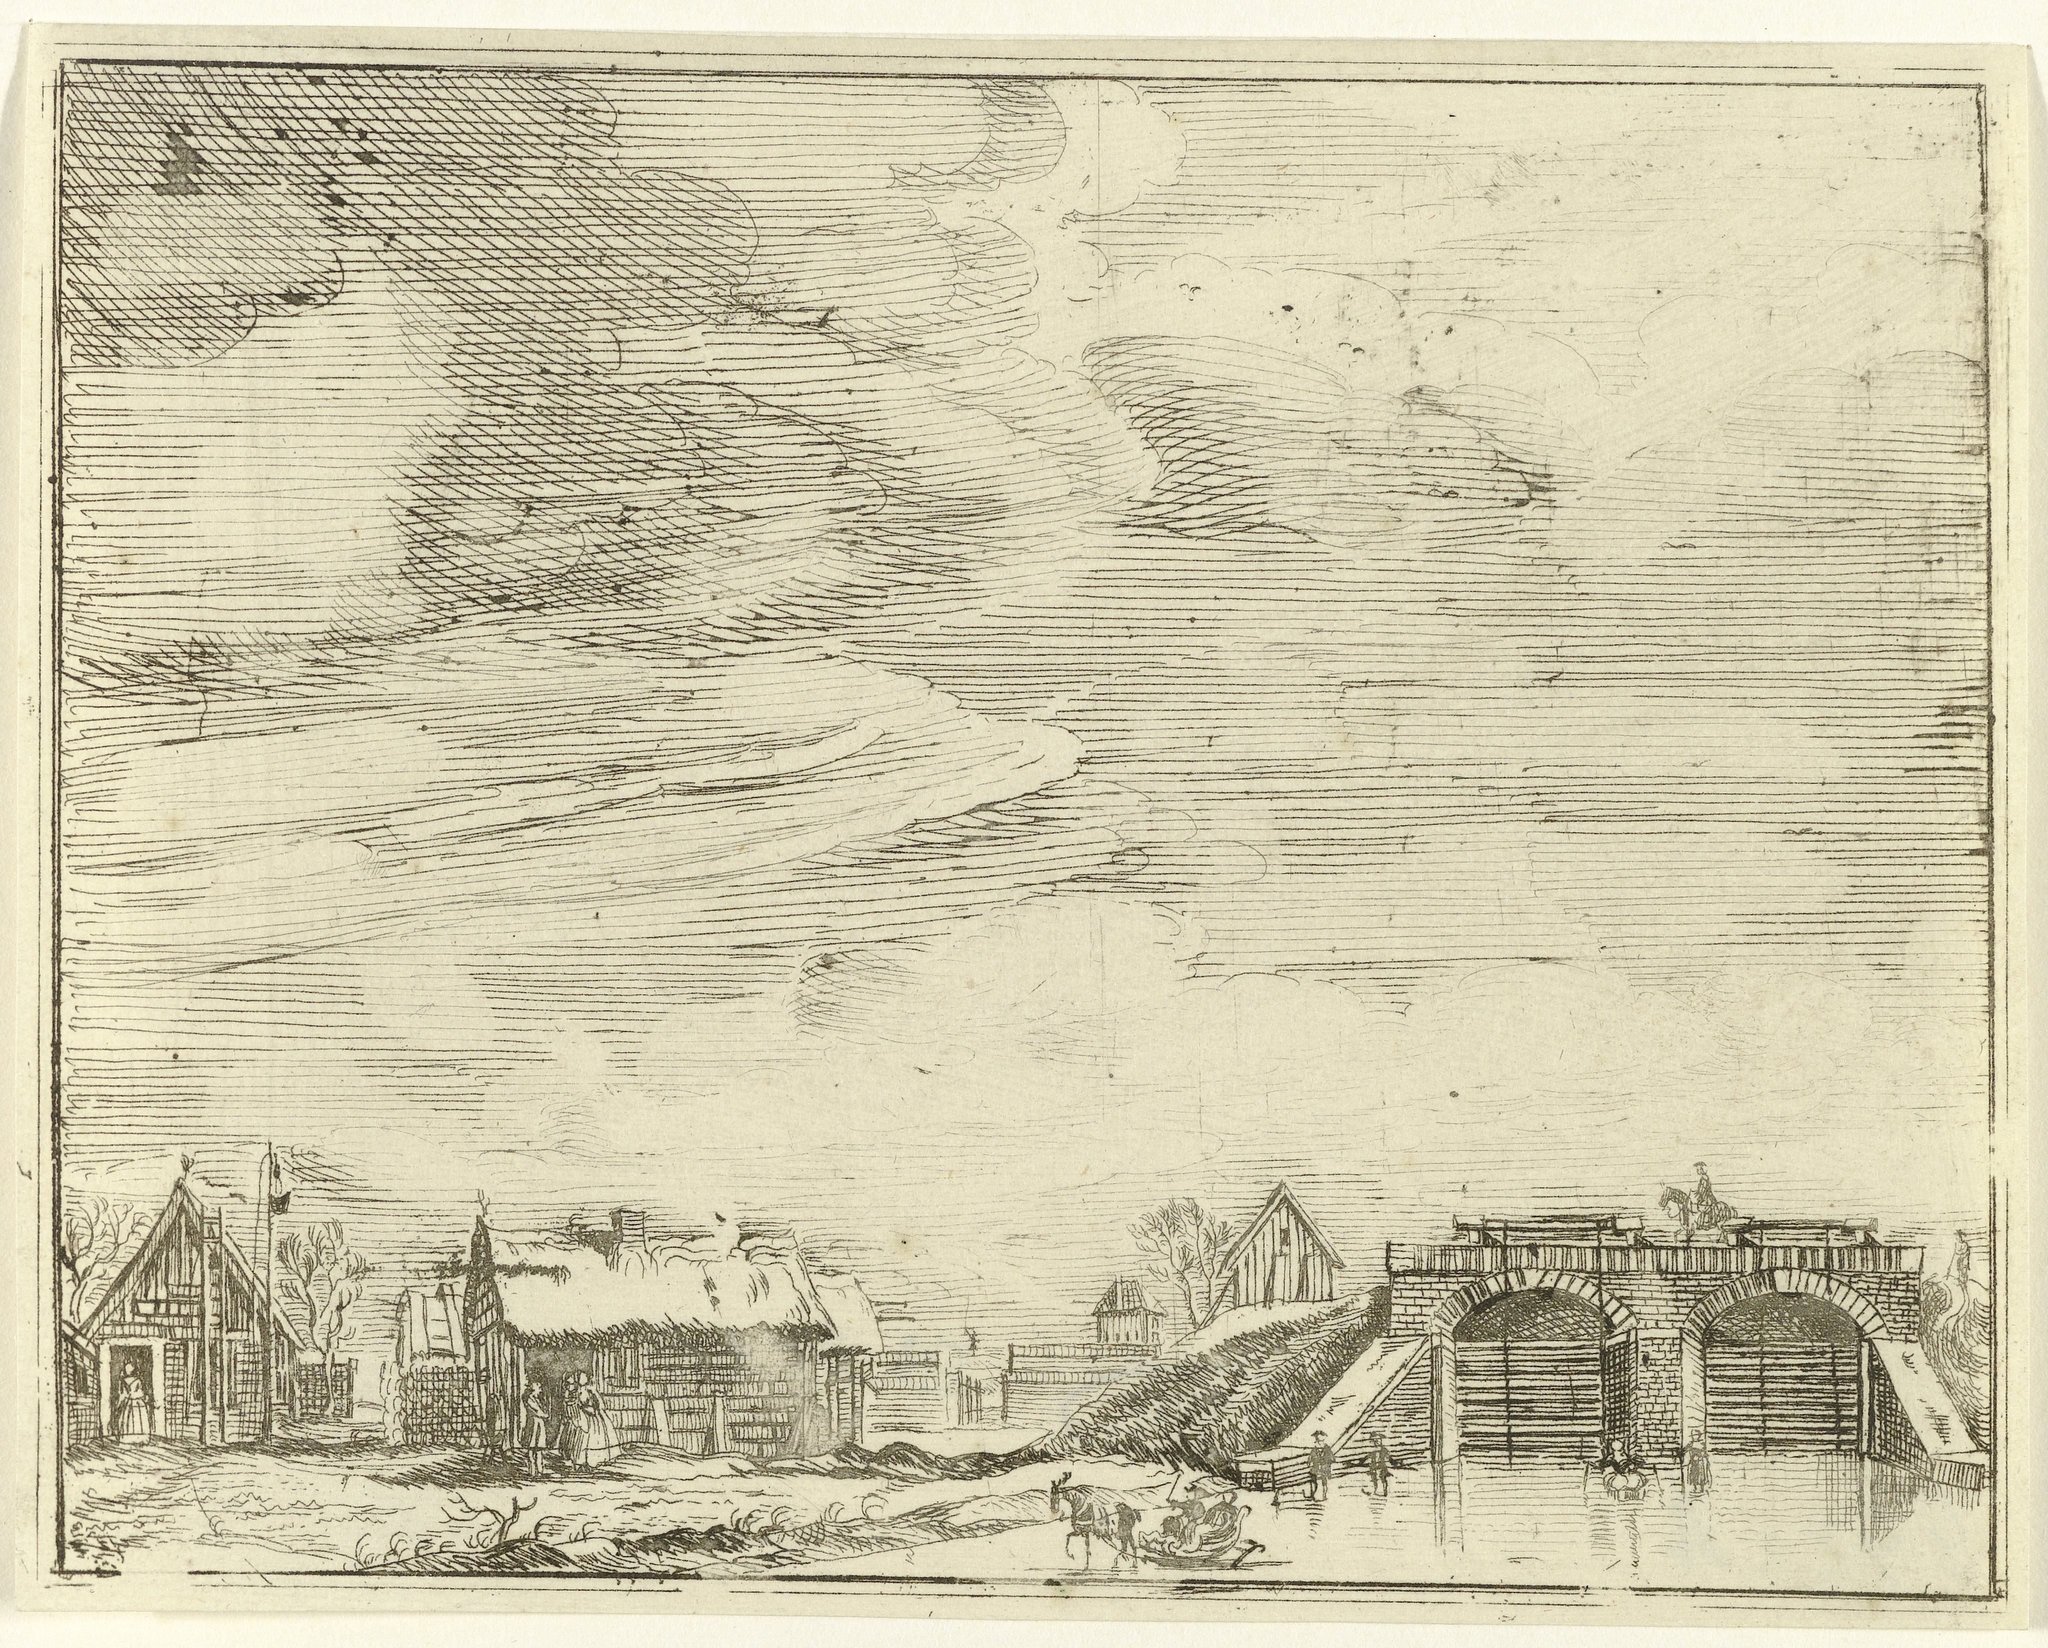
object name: print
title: Fortificatie en schutsluis te Arnhem, de Pruisische Bril genaamd, 1787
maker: Anonymous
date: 1787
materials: paper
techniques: etching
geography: northern netherlands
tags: sluice, weir, arnhem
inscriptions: collector's mark: Lugt 2228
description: Gezicht op de fortificatie en schutsluis te Arnhem, de Pruisische Bril genaamd, ca. 1787, ten tijde van de Pruisische inval in Nederland.